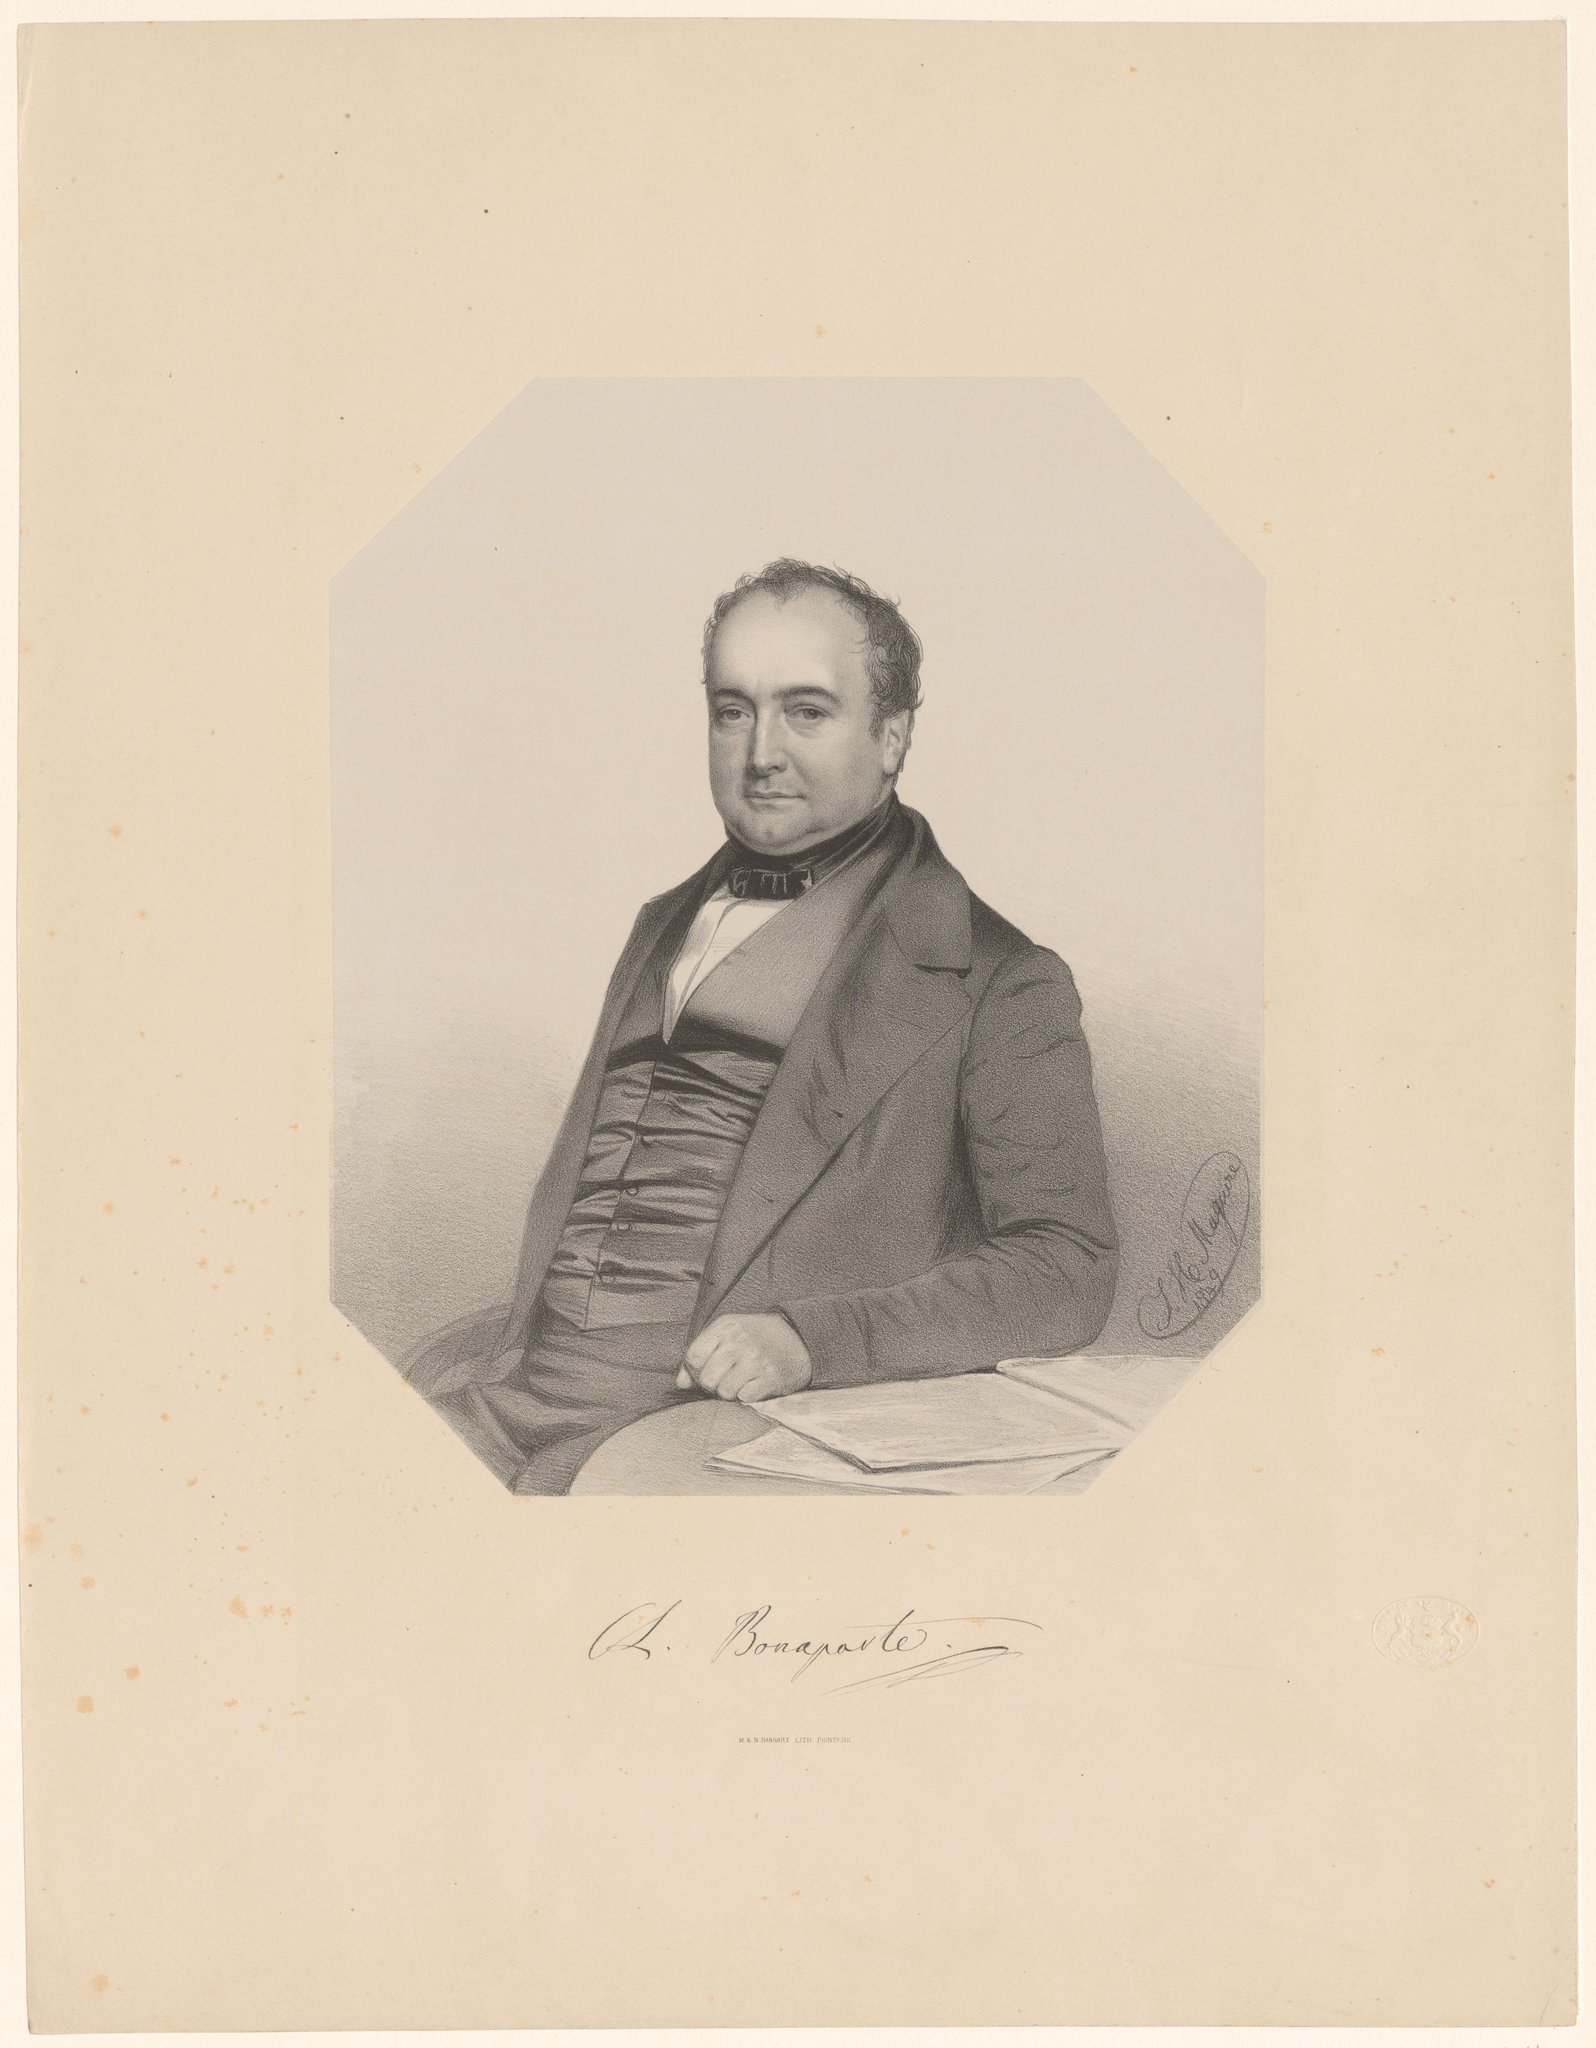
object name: print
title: Portretten uit het Ipswich Museum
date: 1852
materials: paper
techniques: lithograph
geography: london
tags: adult man, historical persons, materials to write on, writing surfaces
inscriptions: check stamp: ‘Ipswich Museum’, collector's mark: Lugt 2228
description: Prent behoort tot de serie 'Ipswich Museum Portraits', ook bekend onder de titel 'Portraits of Honorary Members of the Ipswich Museum'. Deze serie is in 1852 door George Ransome uitgegeven en gedrukt door M&N Hanhart tussen 1848 en 1852. De serie bestaat uit ca. 60 portretten.